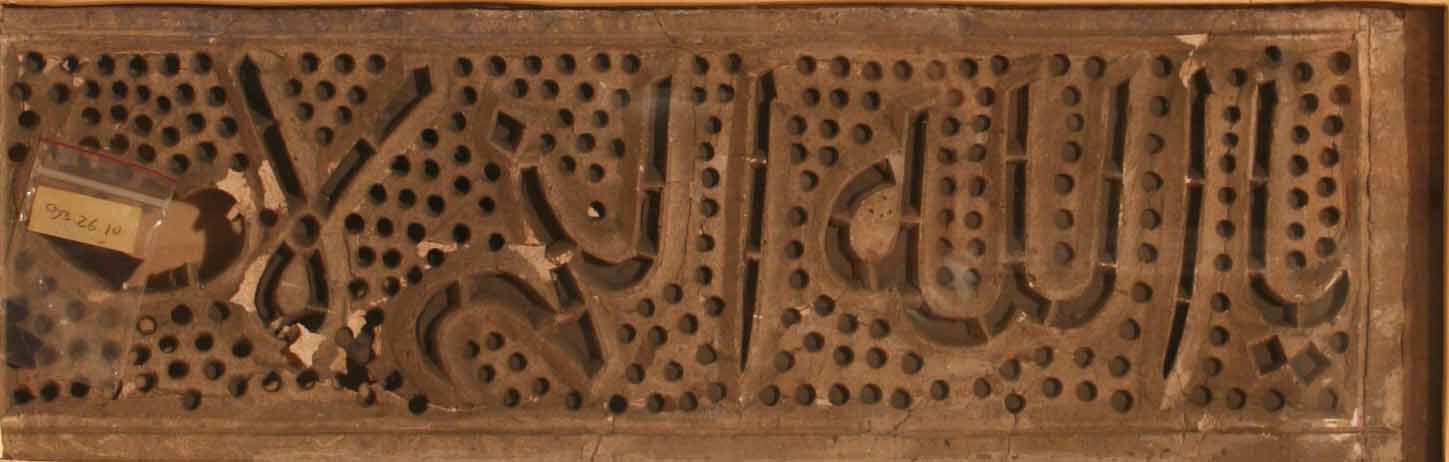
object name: window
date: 1601-1700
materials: gypsum, glass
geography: egypt or syria